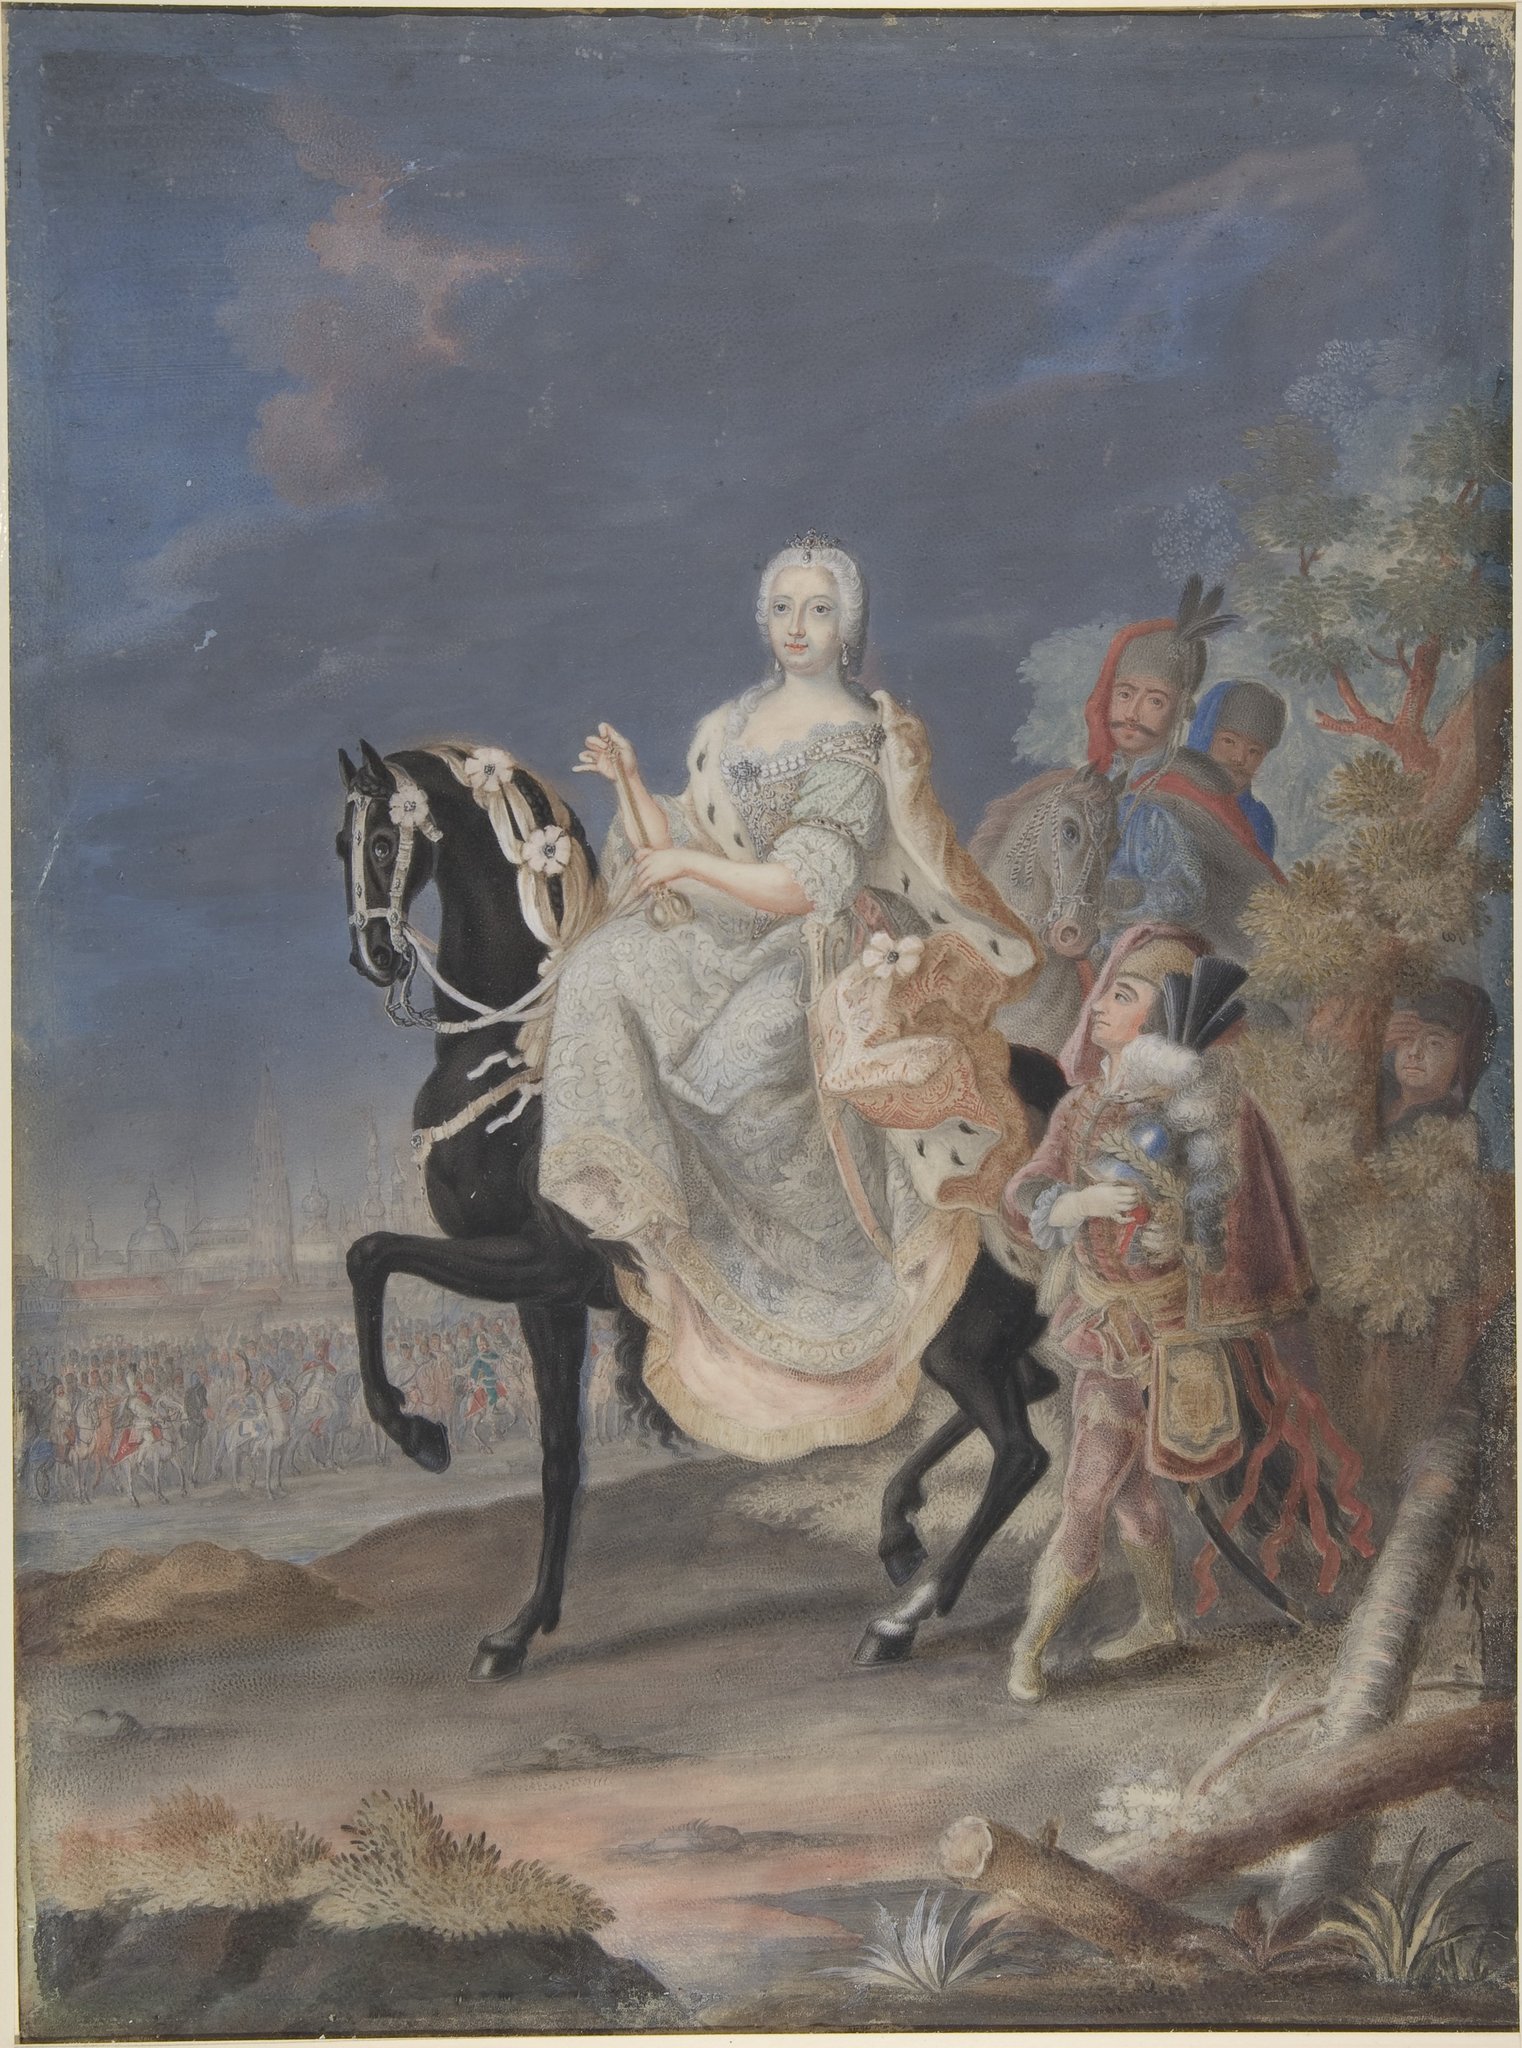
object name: drawing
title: Portrait of Maria Theresa, queen of Hungary and Bohemia, on horseback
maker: anonymous, french, 18th century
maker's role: artist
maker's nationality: french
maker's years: 1700-1800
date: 1701-1800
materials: parchment, watercolor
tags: men,women,horses,trees